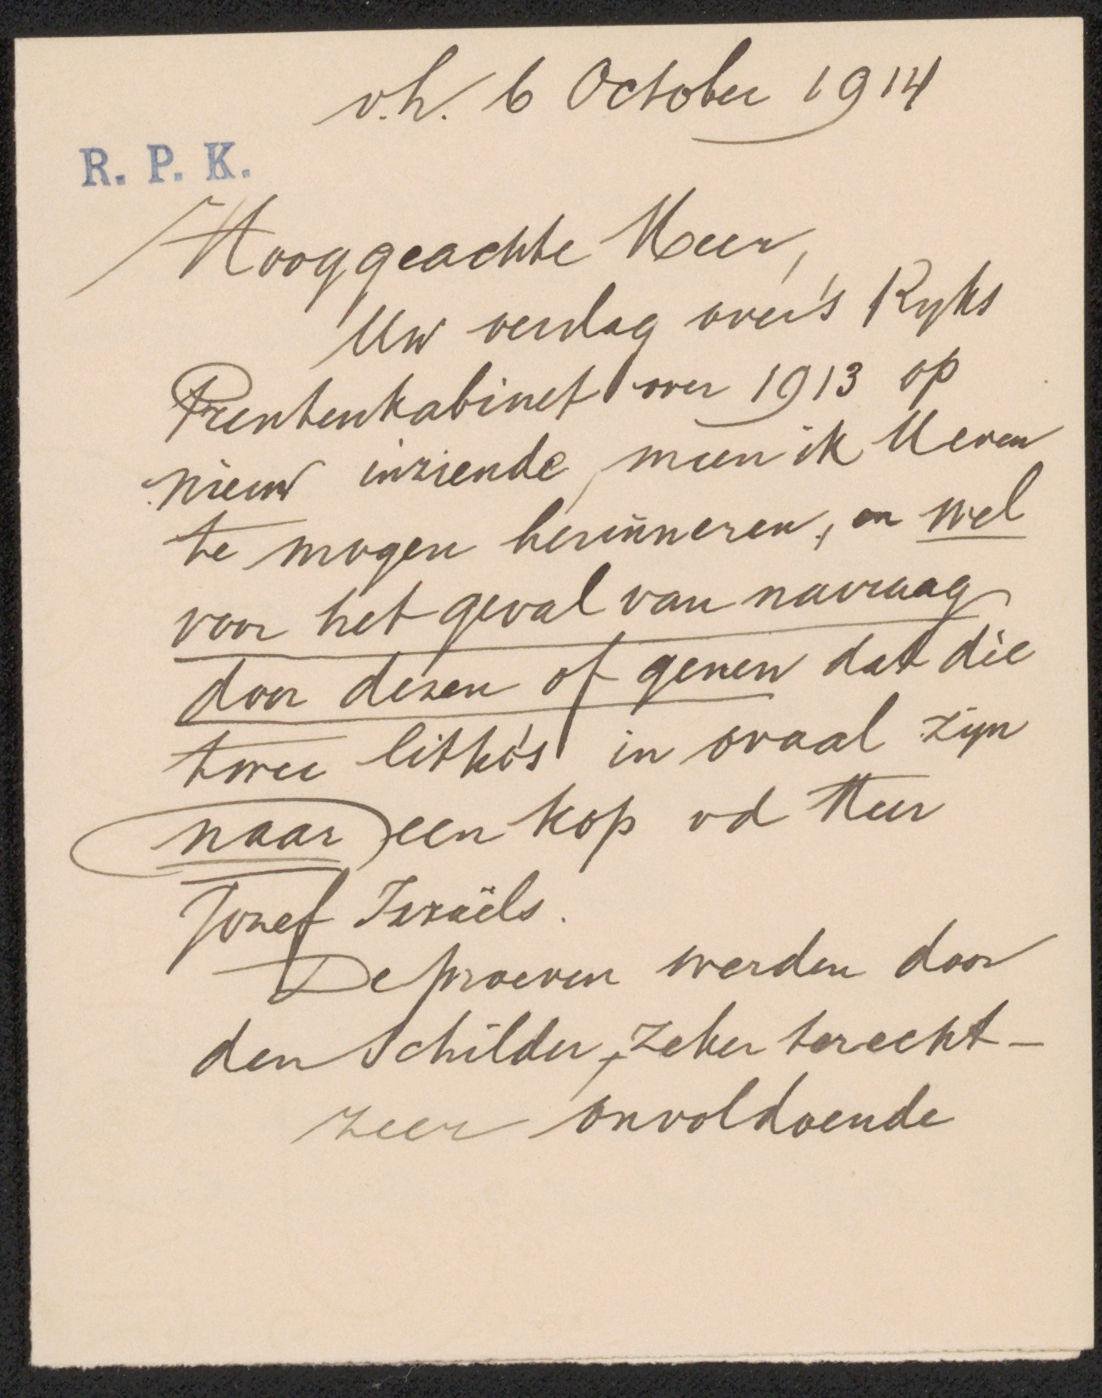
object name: letter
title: Brief aan jonkheer Hendrik Teding van Berkhout (1979-1969)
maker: august allebé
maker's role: draughtsman, print maker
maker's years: 1838-1927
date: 1914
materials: ink, paper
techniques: pen, writing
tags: the hague, painter, print maker, draughtsman, jozef israëls, print room, haarlem, amsterdam, jonkheer hendrik teding van berkhout (1879-1969), the graphic arts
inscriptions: collector's mark: Lugt 2233